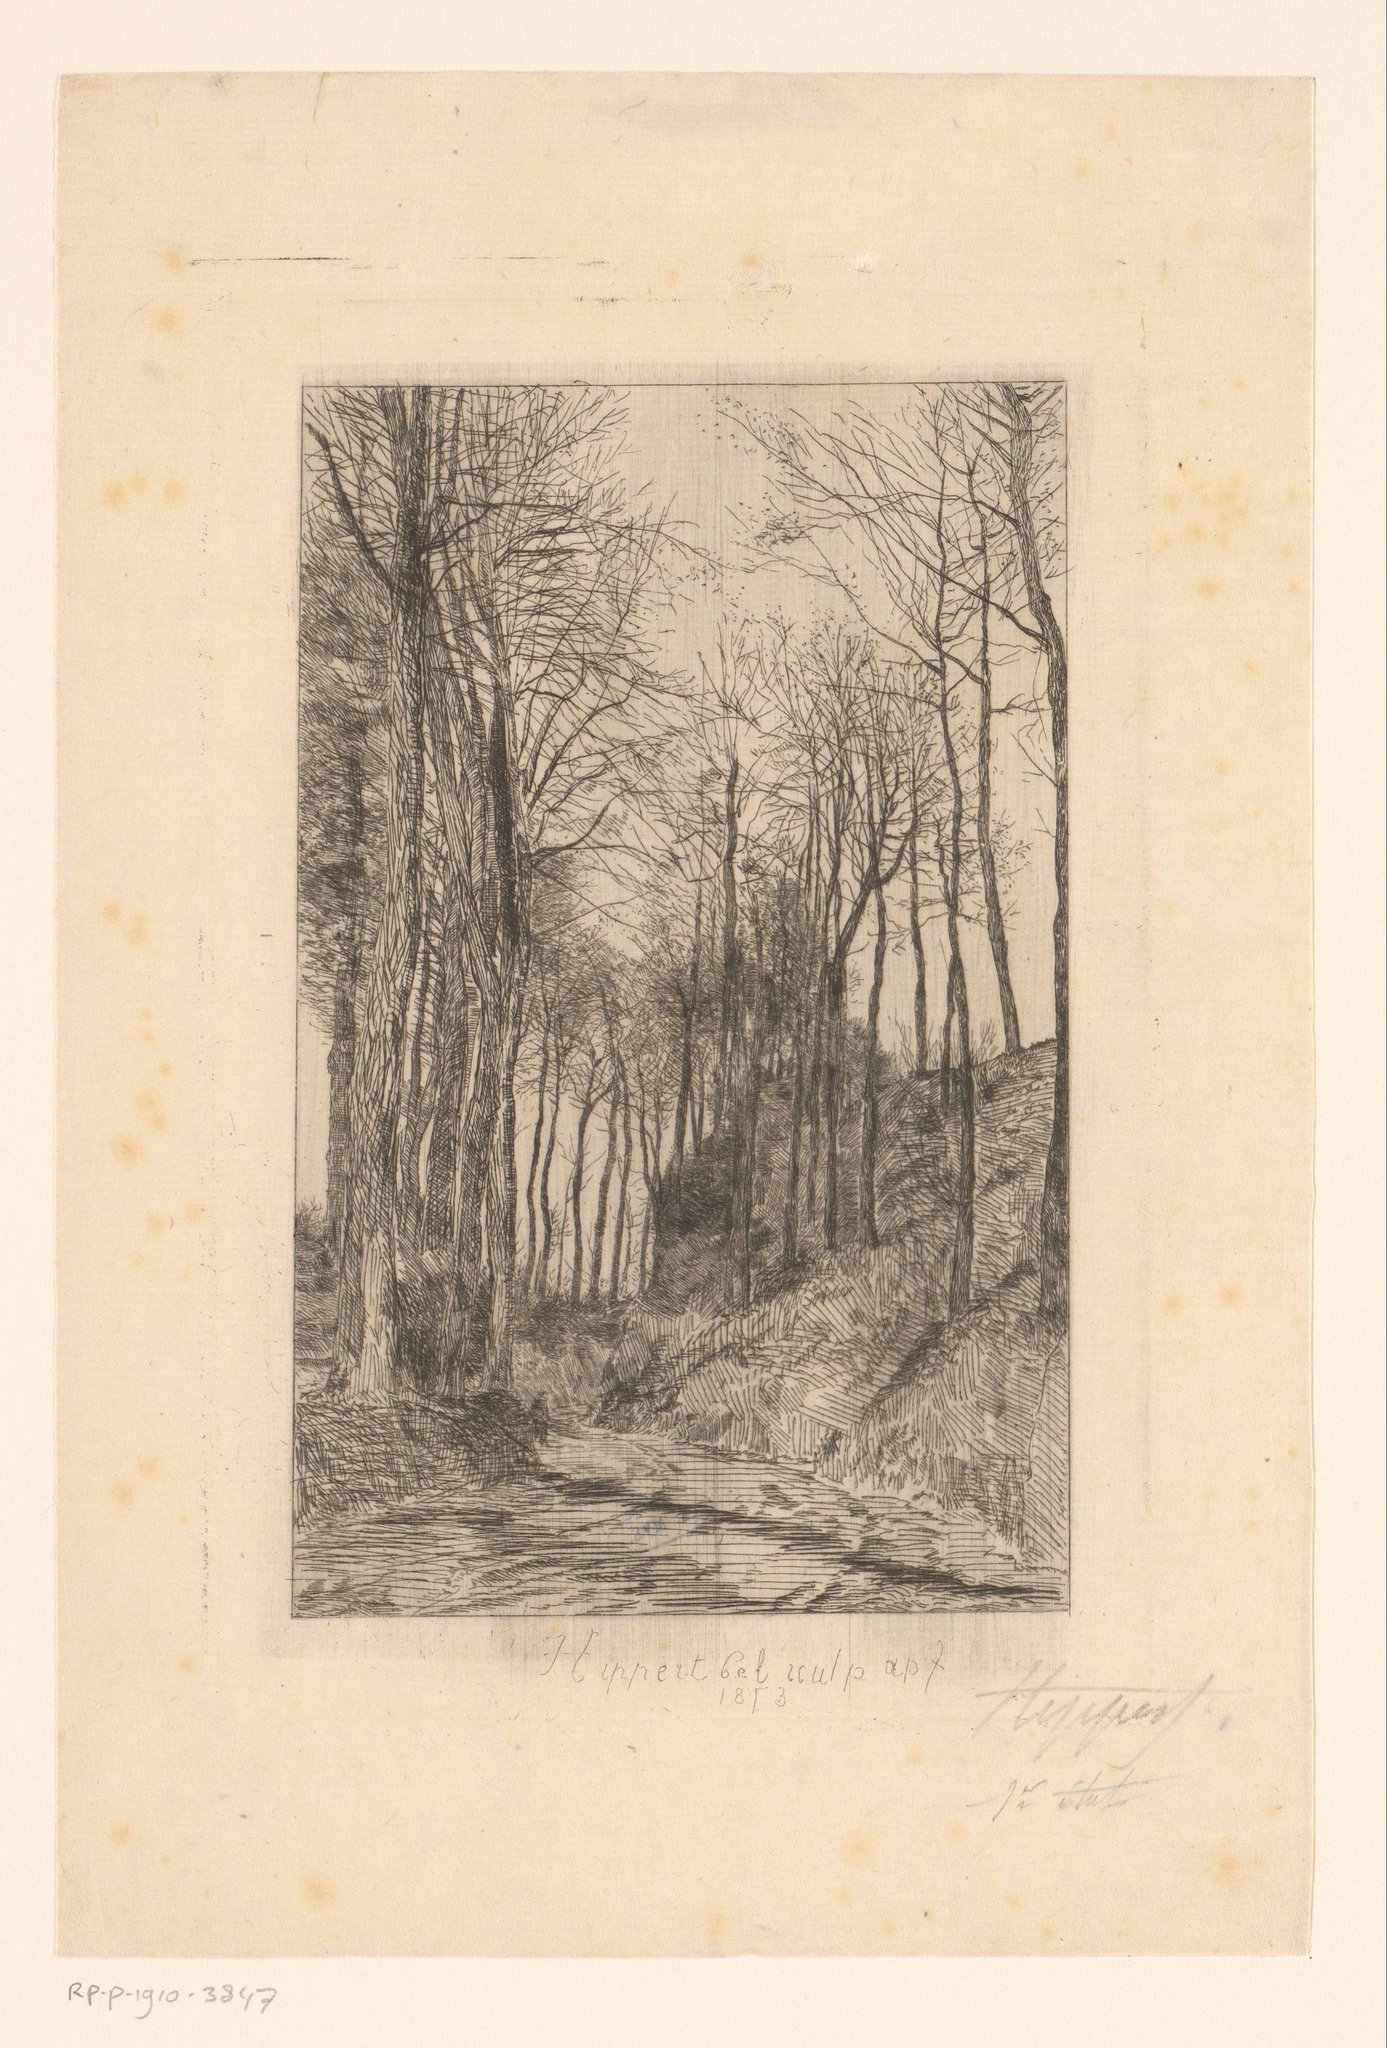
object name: print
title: Landweg langs heuvels met bomen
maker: karel theodoor hippert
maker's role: print maker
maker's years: 1839-1919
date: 1873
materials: paper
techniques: etching, intaglio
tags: low hill country, trees, forest path or lane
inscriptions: collector's mark: Lugt 2228